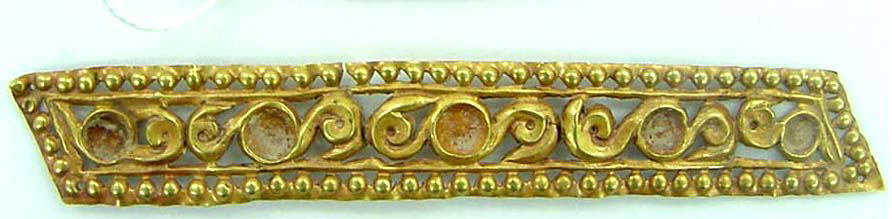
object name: plaque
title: Oblong Plaque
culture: northwest chinese or eastern central asian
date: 634-900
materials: gold